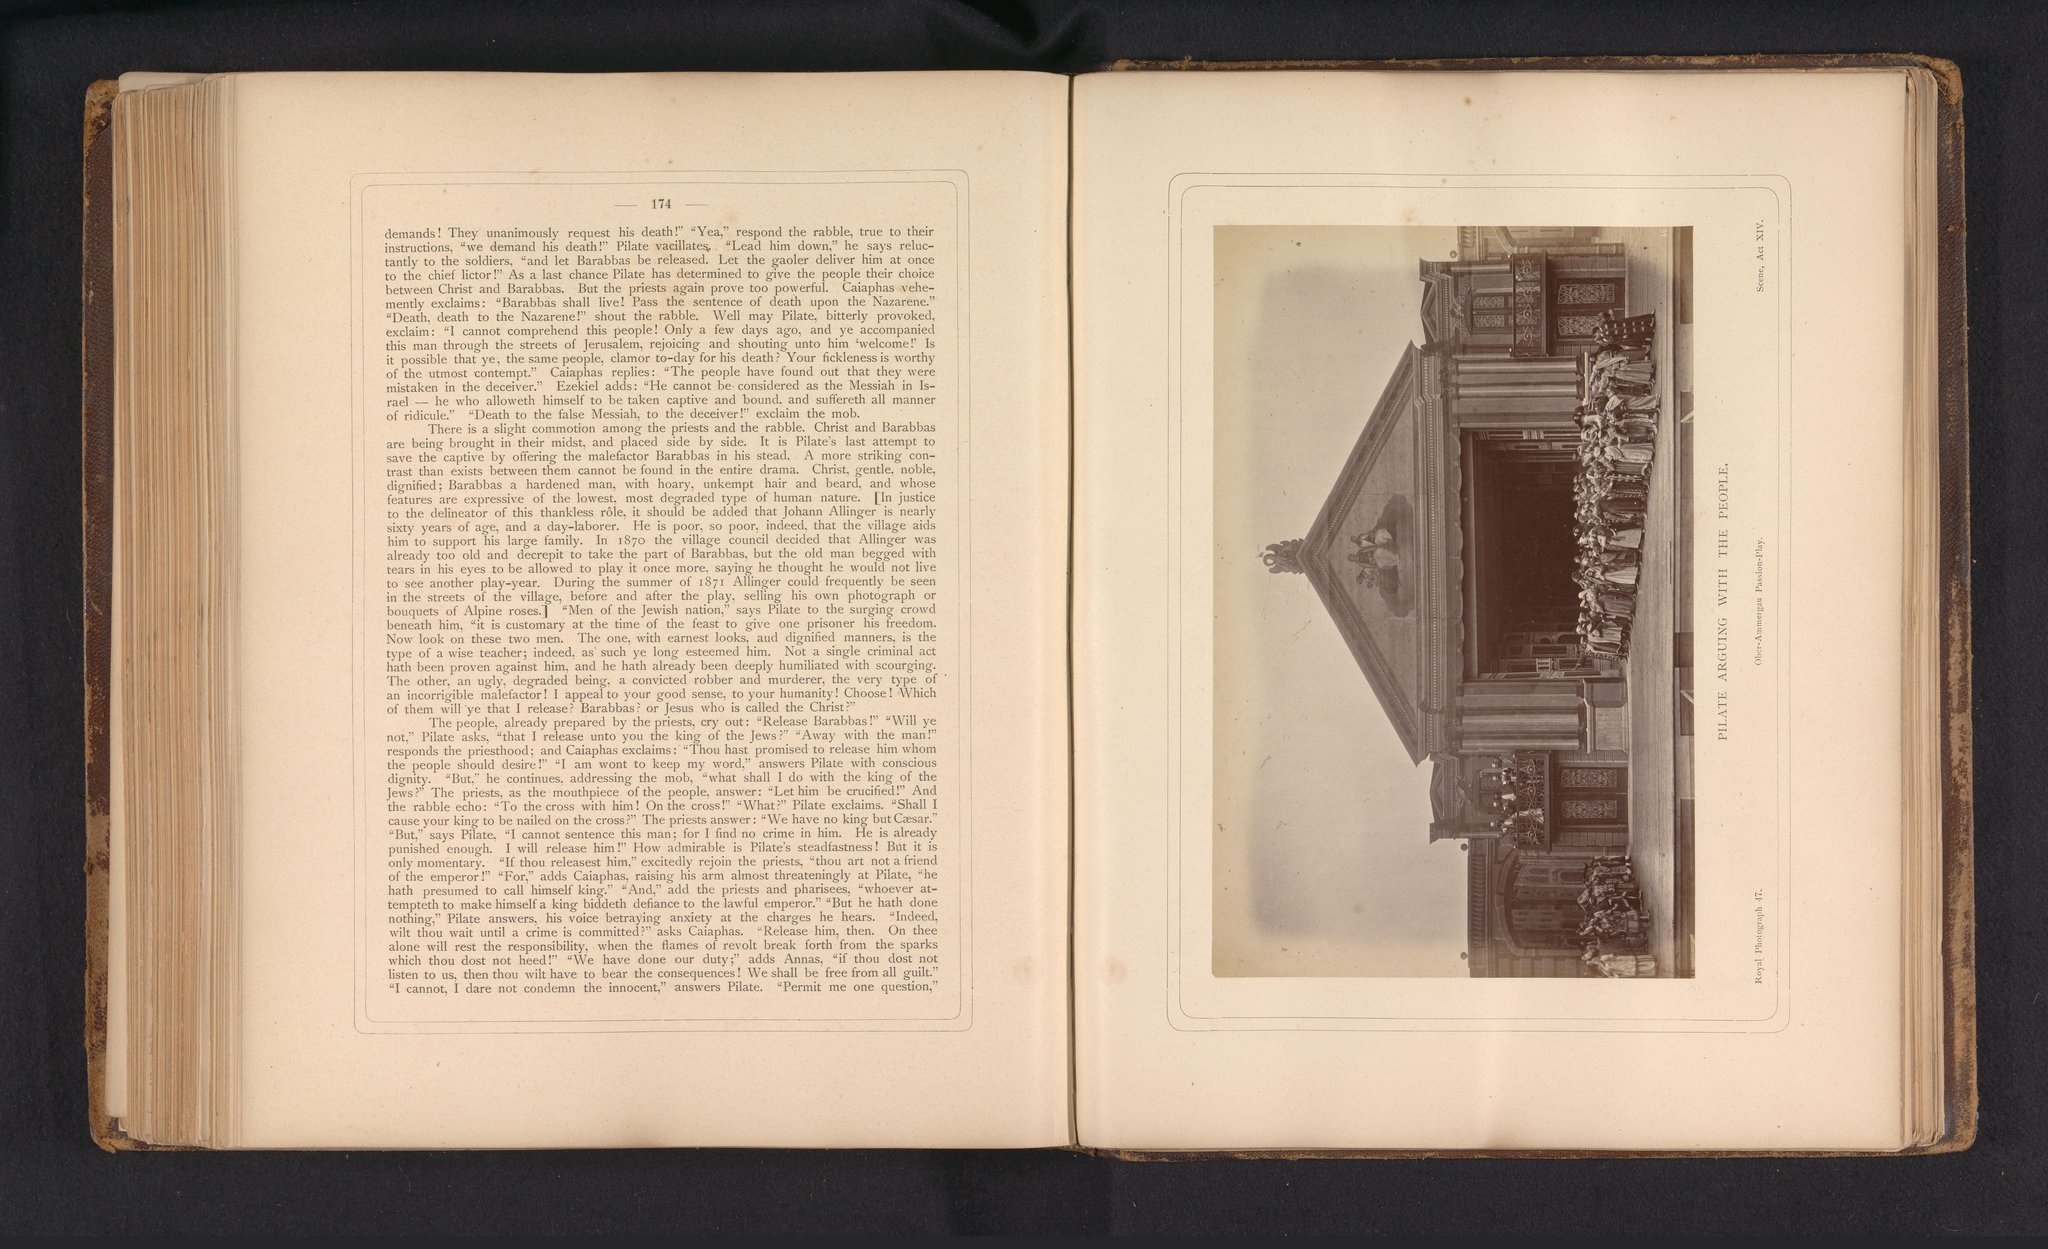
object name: photograph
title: Pilate arguing with the people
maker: joseph albert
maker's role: printer, publisher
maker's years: 1825-1886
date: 1868-1873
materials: photographic support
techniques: albumen print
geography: oberammergau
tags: group of actors, troupe; actors on the stage, pilate in debate with the jews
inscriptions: number: ‘46’, number: ‘Royal Photograph 47.’